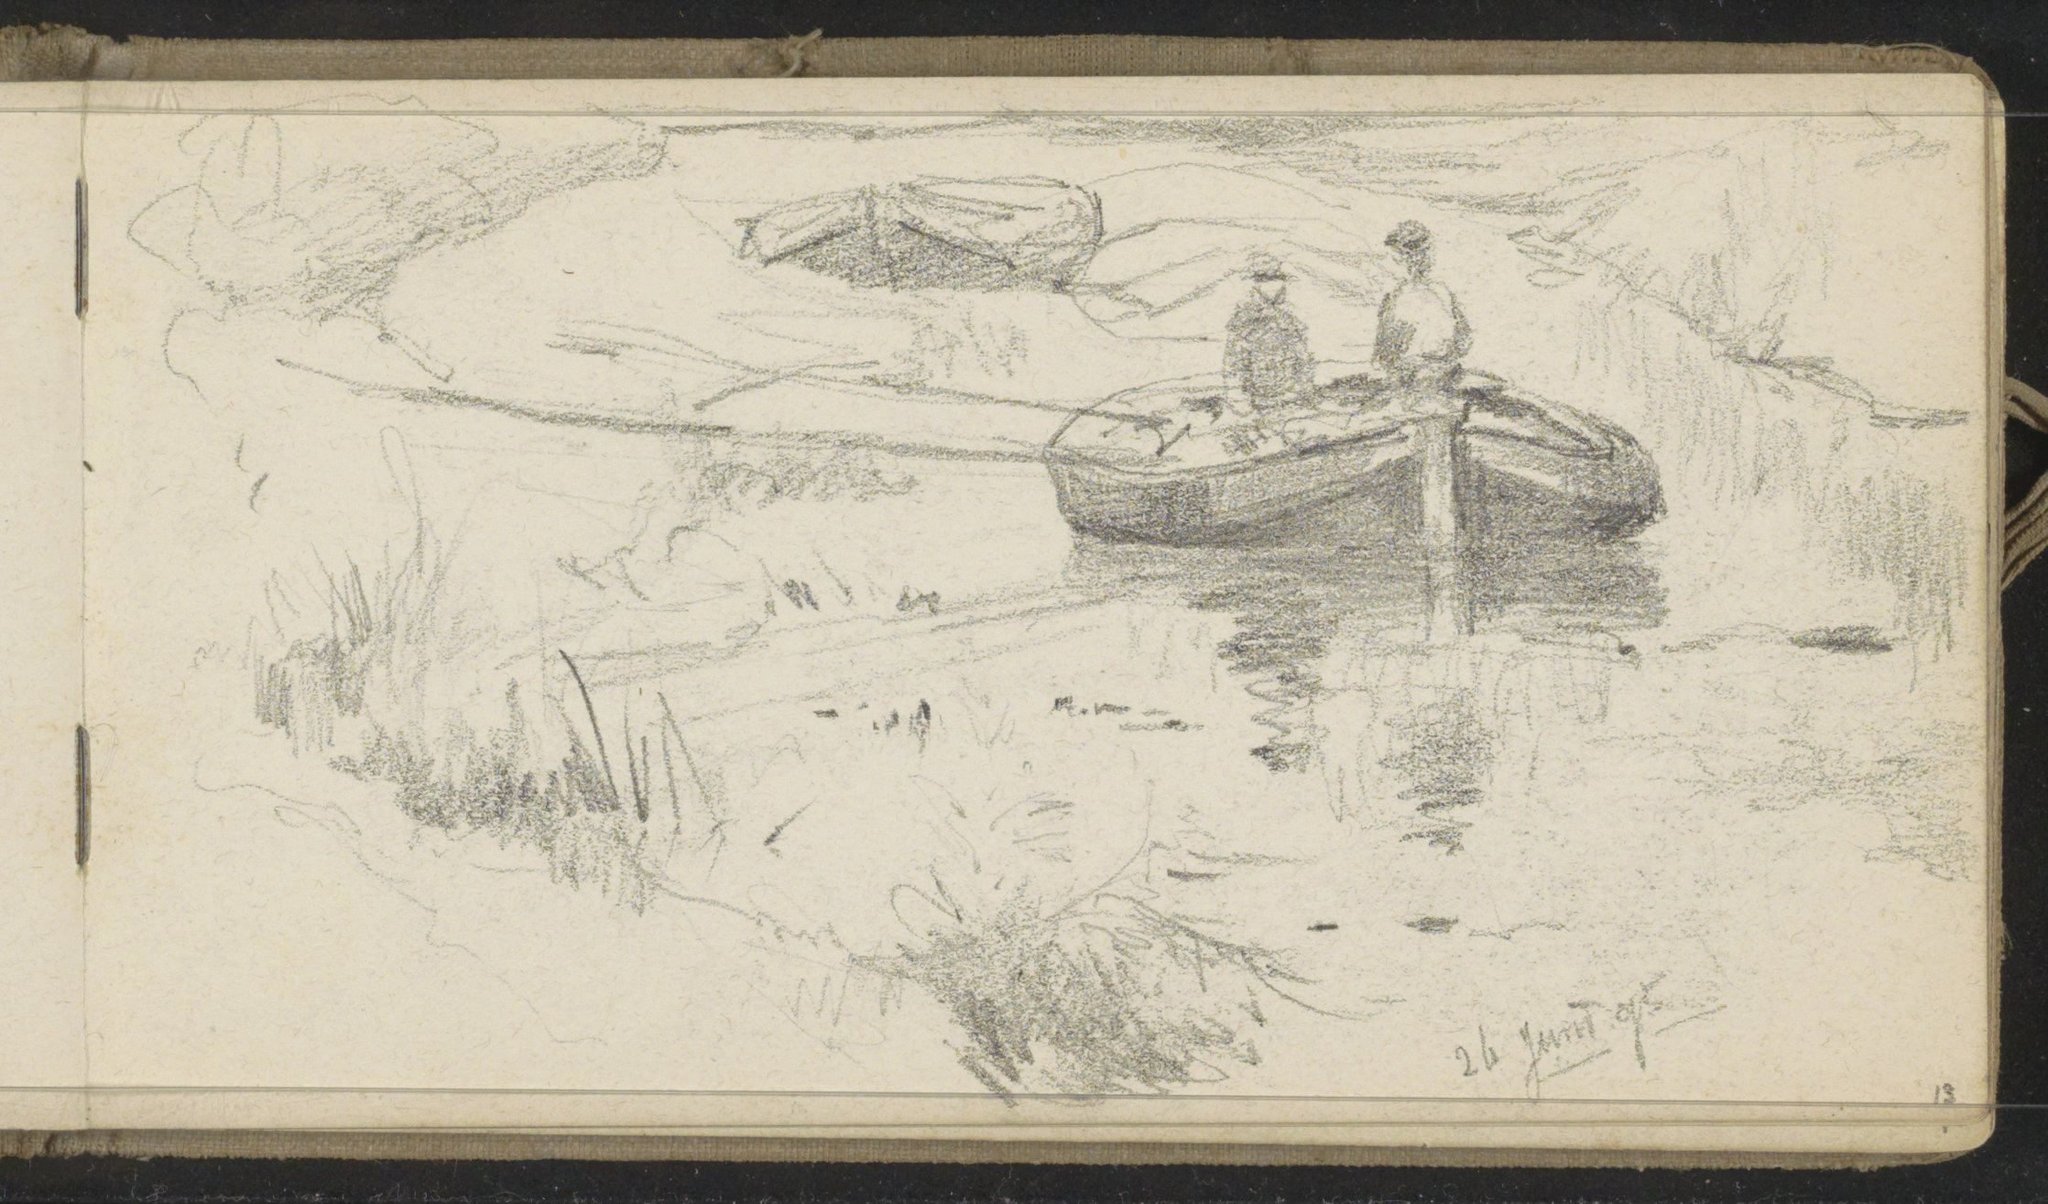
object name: sketchbook leaf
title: Twee figuren in een roeiboot op het water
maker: willem cornelis rip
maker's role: draughtsman, painter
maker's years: 1856-1922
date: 1806-1895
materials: paper, pencil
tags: rowing-boat, canoe, etc., landscapes with waters, waterscapes, seascapes (in the temperate zone) (+ landscape with figures, staffage)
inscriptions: date: ‘25 Juni 95’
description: Blad 13 recto uit een schetsboek met 39 bladen.